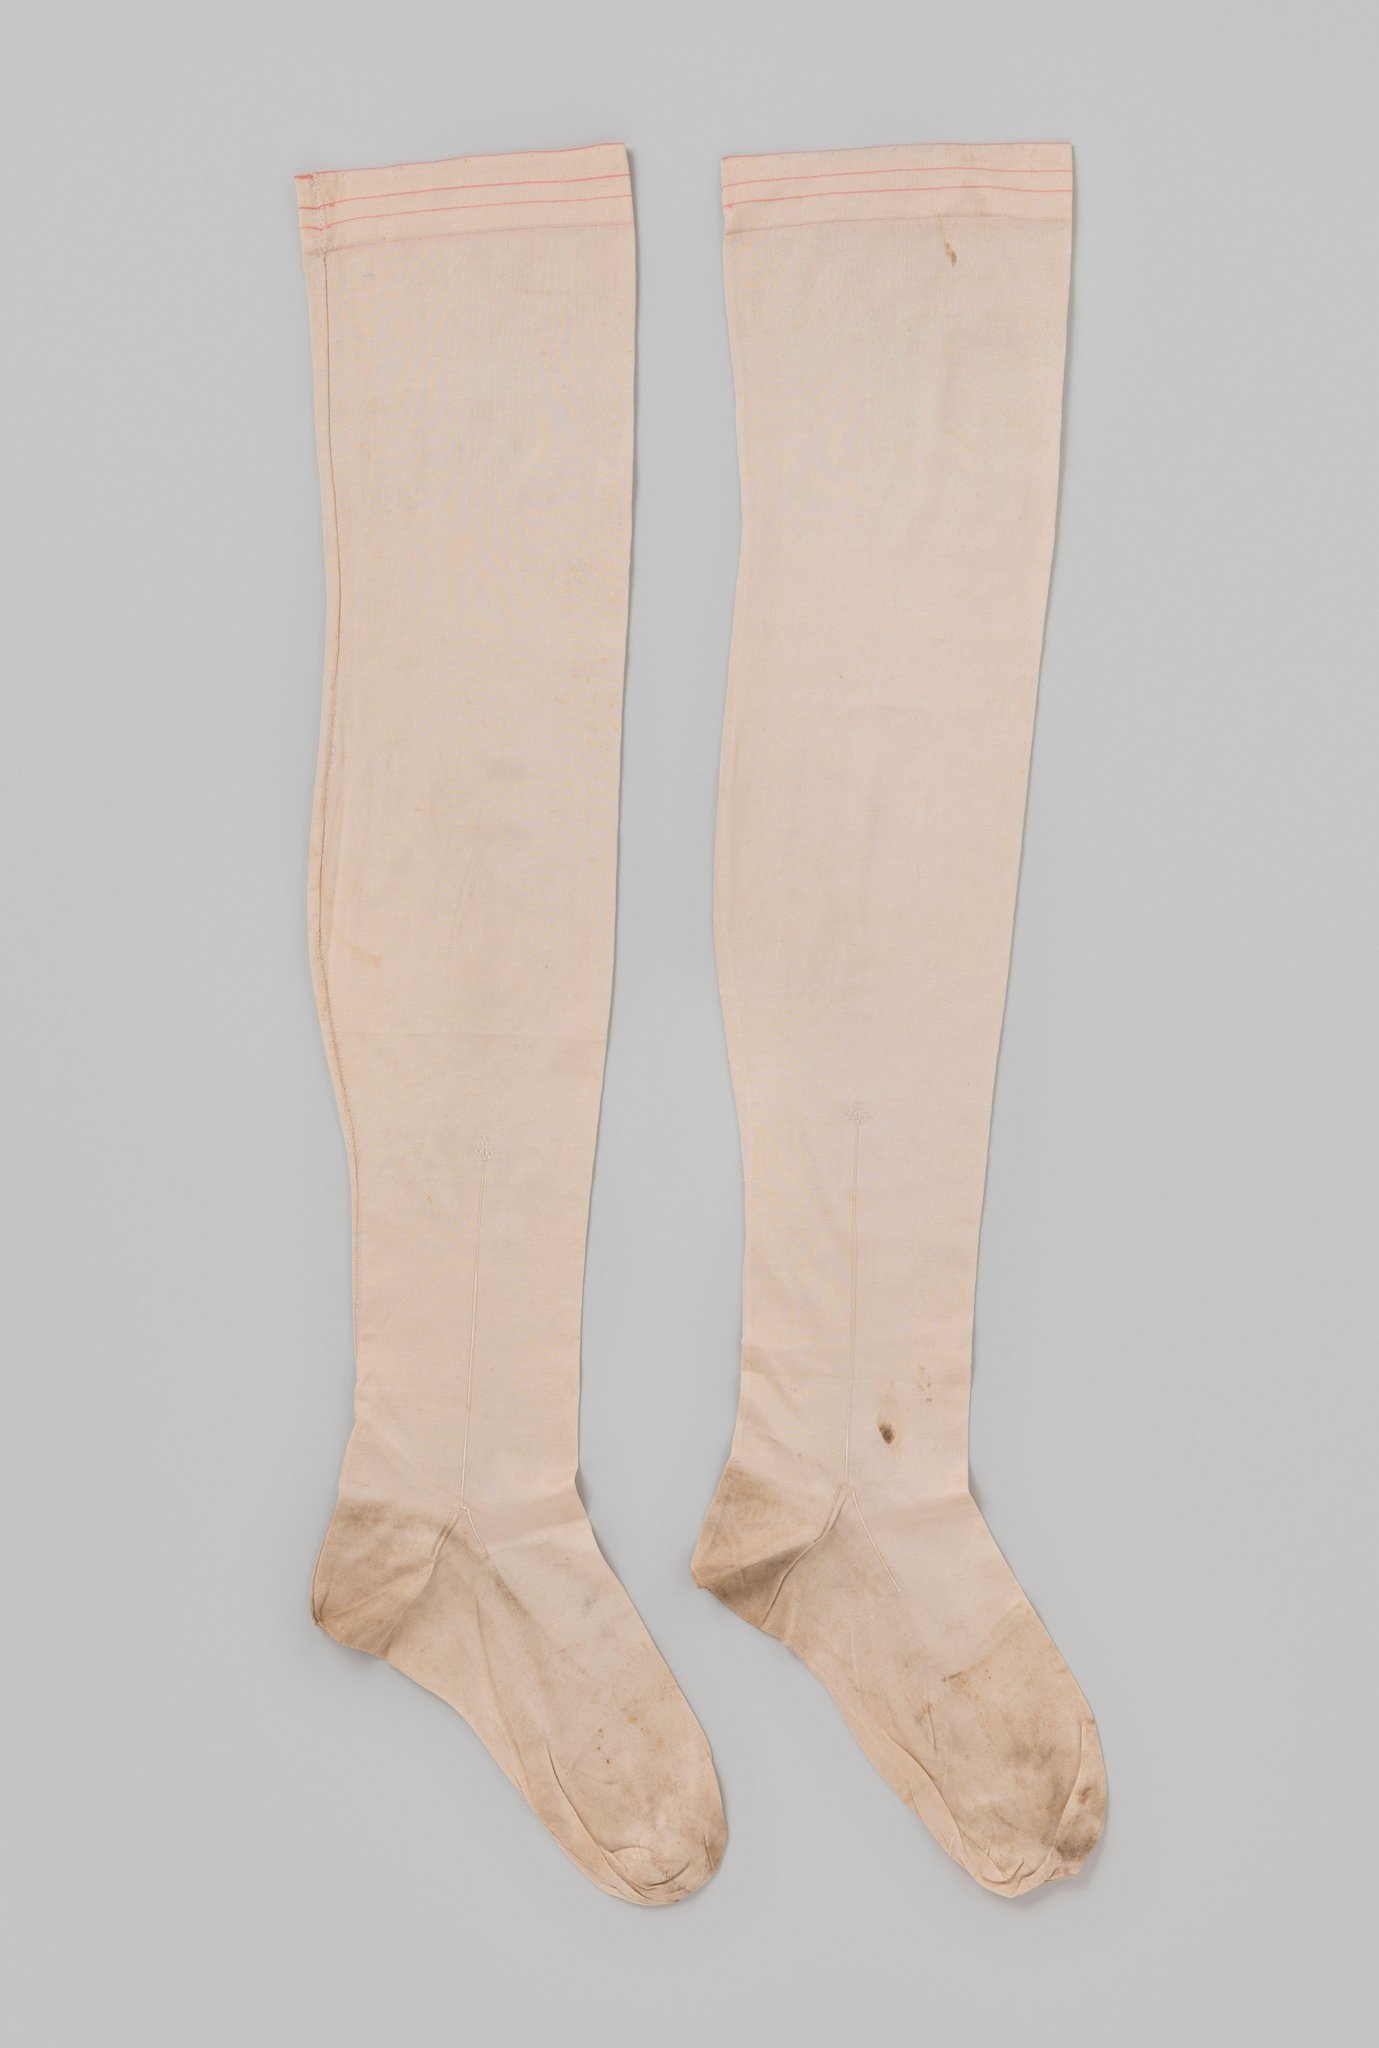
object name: stocking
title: Kous van witte zijde in tricotsteek, bovenaan met drie roze smalle strepen en onderaan met één geborduurde sierlijn met bloem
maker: Anonymous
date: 1815-1830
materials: silk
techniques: embroidered, knitting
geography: netherlands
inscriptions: mark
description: In tricotsteek gebreide kous van witte zijde, bovenaan met drie roze smalle strepen en twee merktekens en onderaan met één geborduurde sierlijn met bloem. Mogelijk hofkleding.